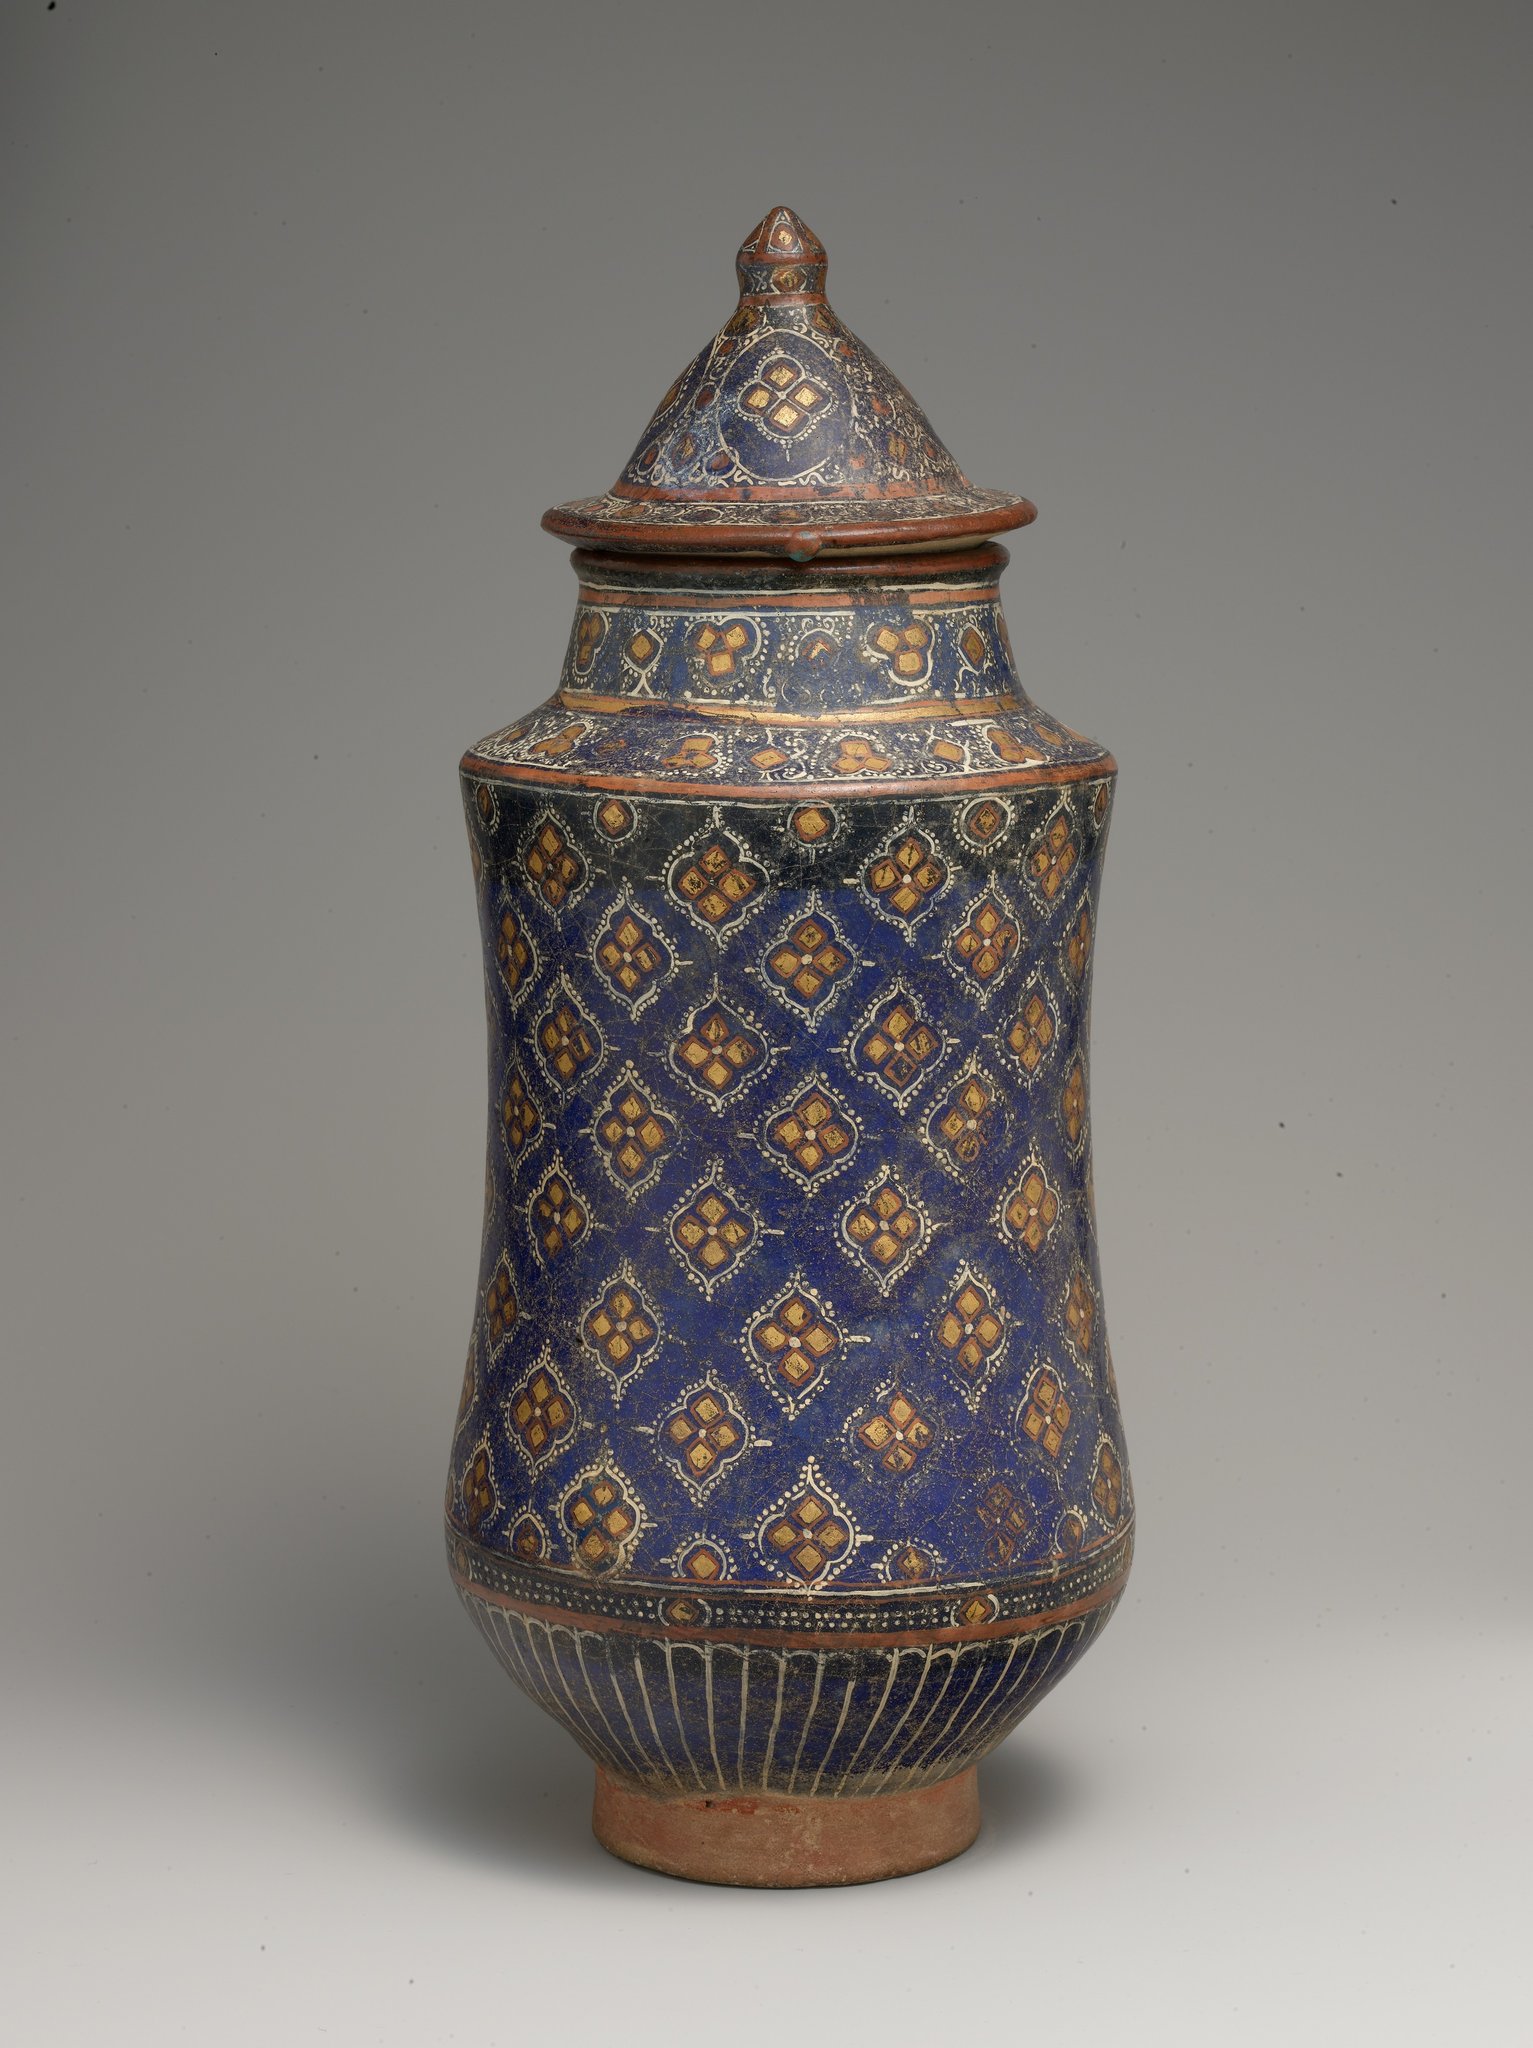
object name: jar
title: Covered Jar (Albarello)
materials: stonepaste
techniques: gilding, overglaze, painting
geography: iran